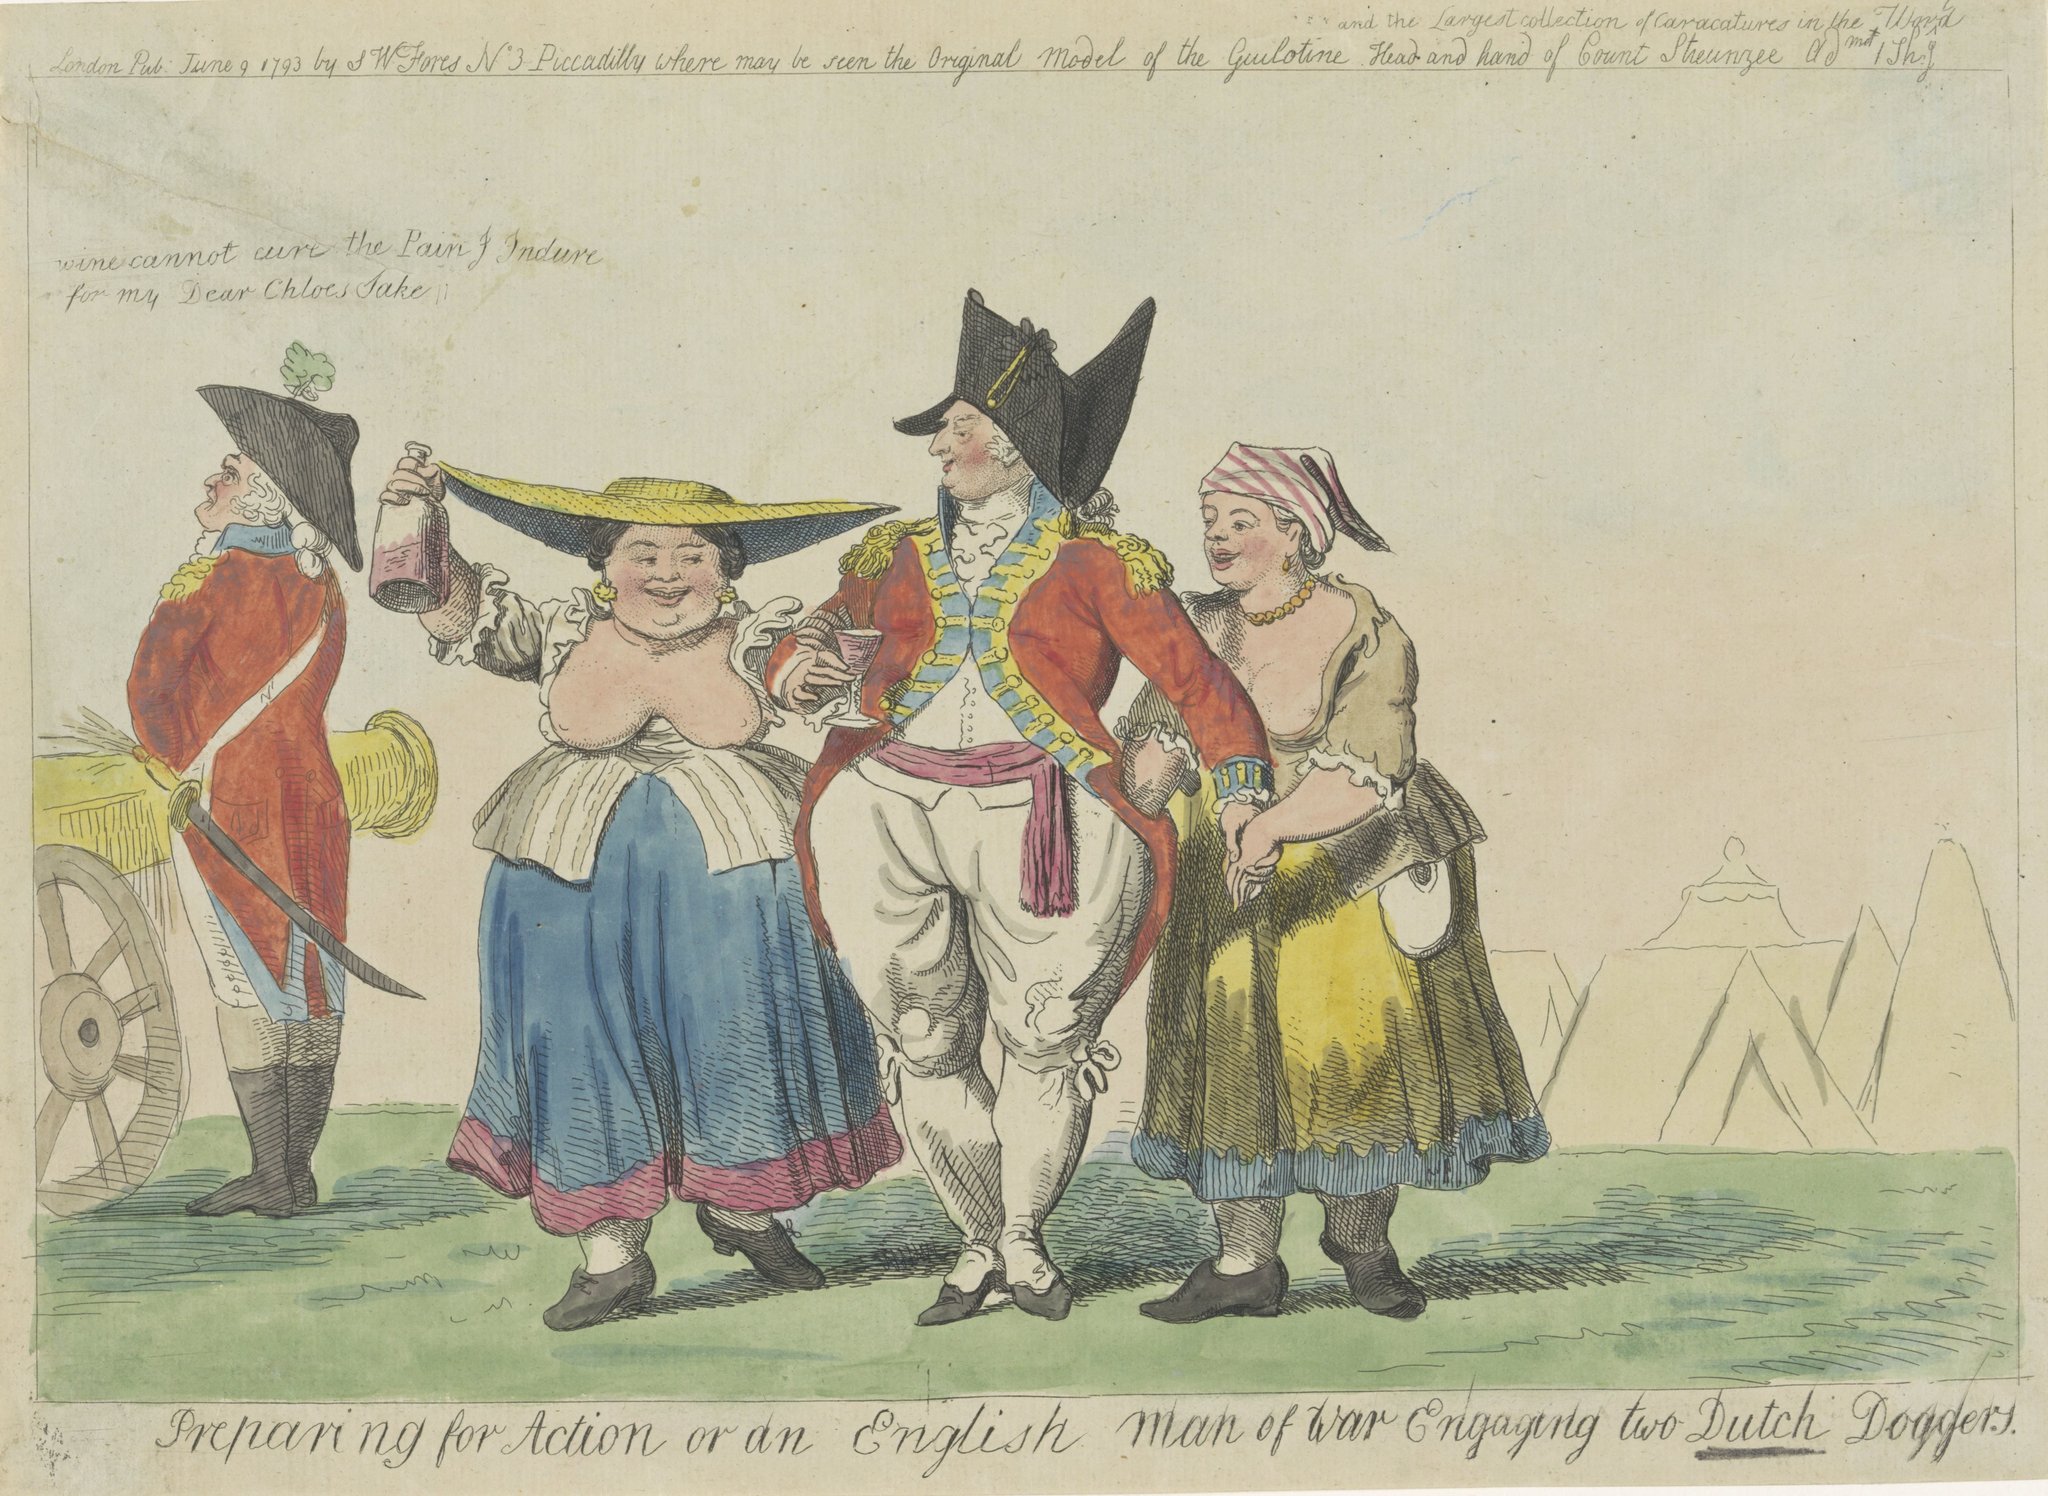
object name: print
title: Engelse commandant met twee Hollandse lichtekooien, 1793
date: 1793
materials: paper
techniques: etching, hand coloring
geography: london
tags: london, frederik (hertog van york en albany), soldiers and civilians, whore, prostitute, pickpocket - gg - female, urination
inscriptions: collector's mark: Lugt 2228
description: Spotprent waarin een Engelse commandant, Frederik Augustus, hertog van York, gearmd loopt tussen twee Hollandse prostitués met ontblote borsten, waarvan één zijn zakken rolt. Links urineert een andere Engelsman tegen een kanon, in een legerkamp. Naar aanleiding van het optreden van het Coalitieleger in de Nederlanden in 1793.